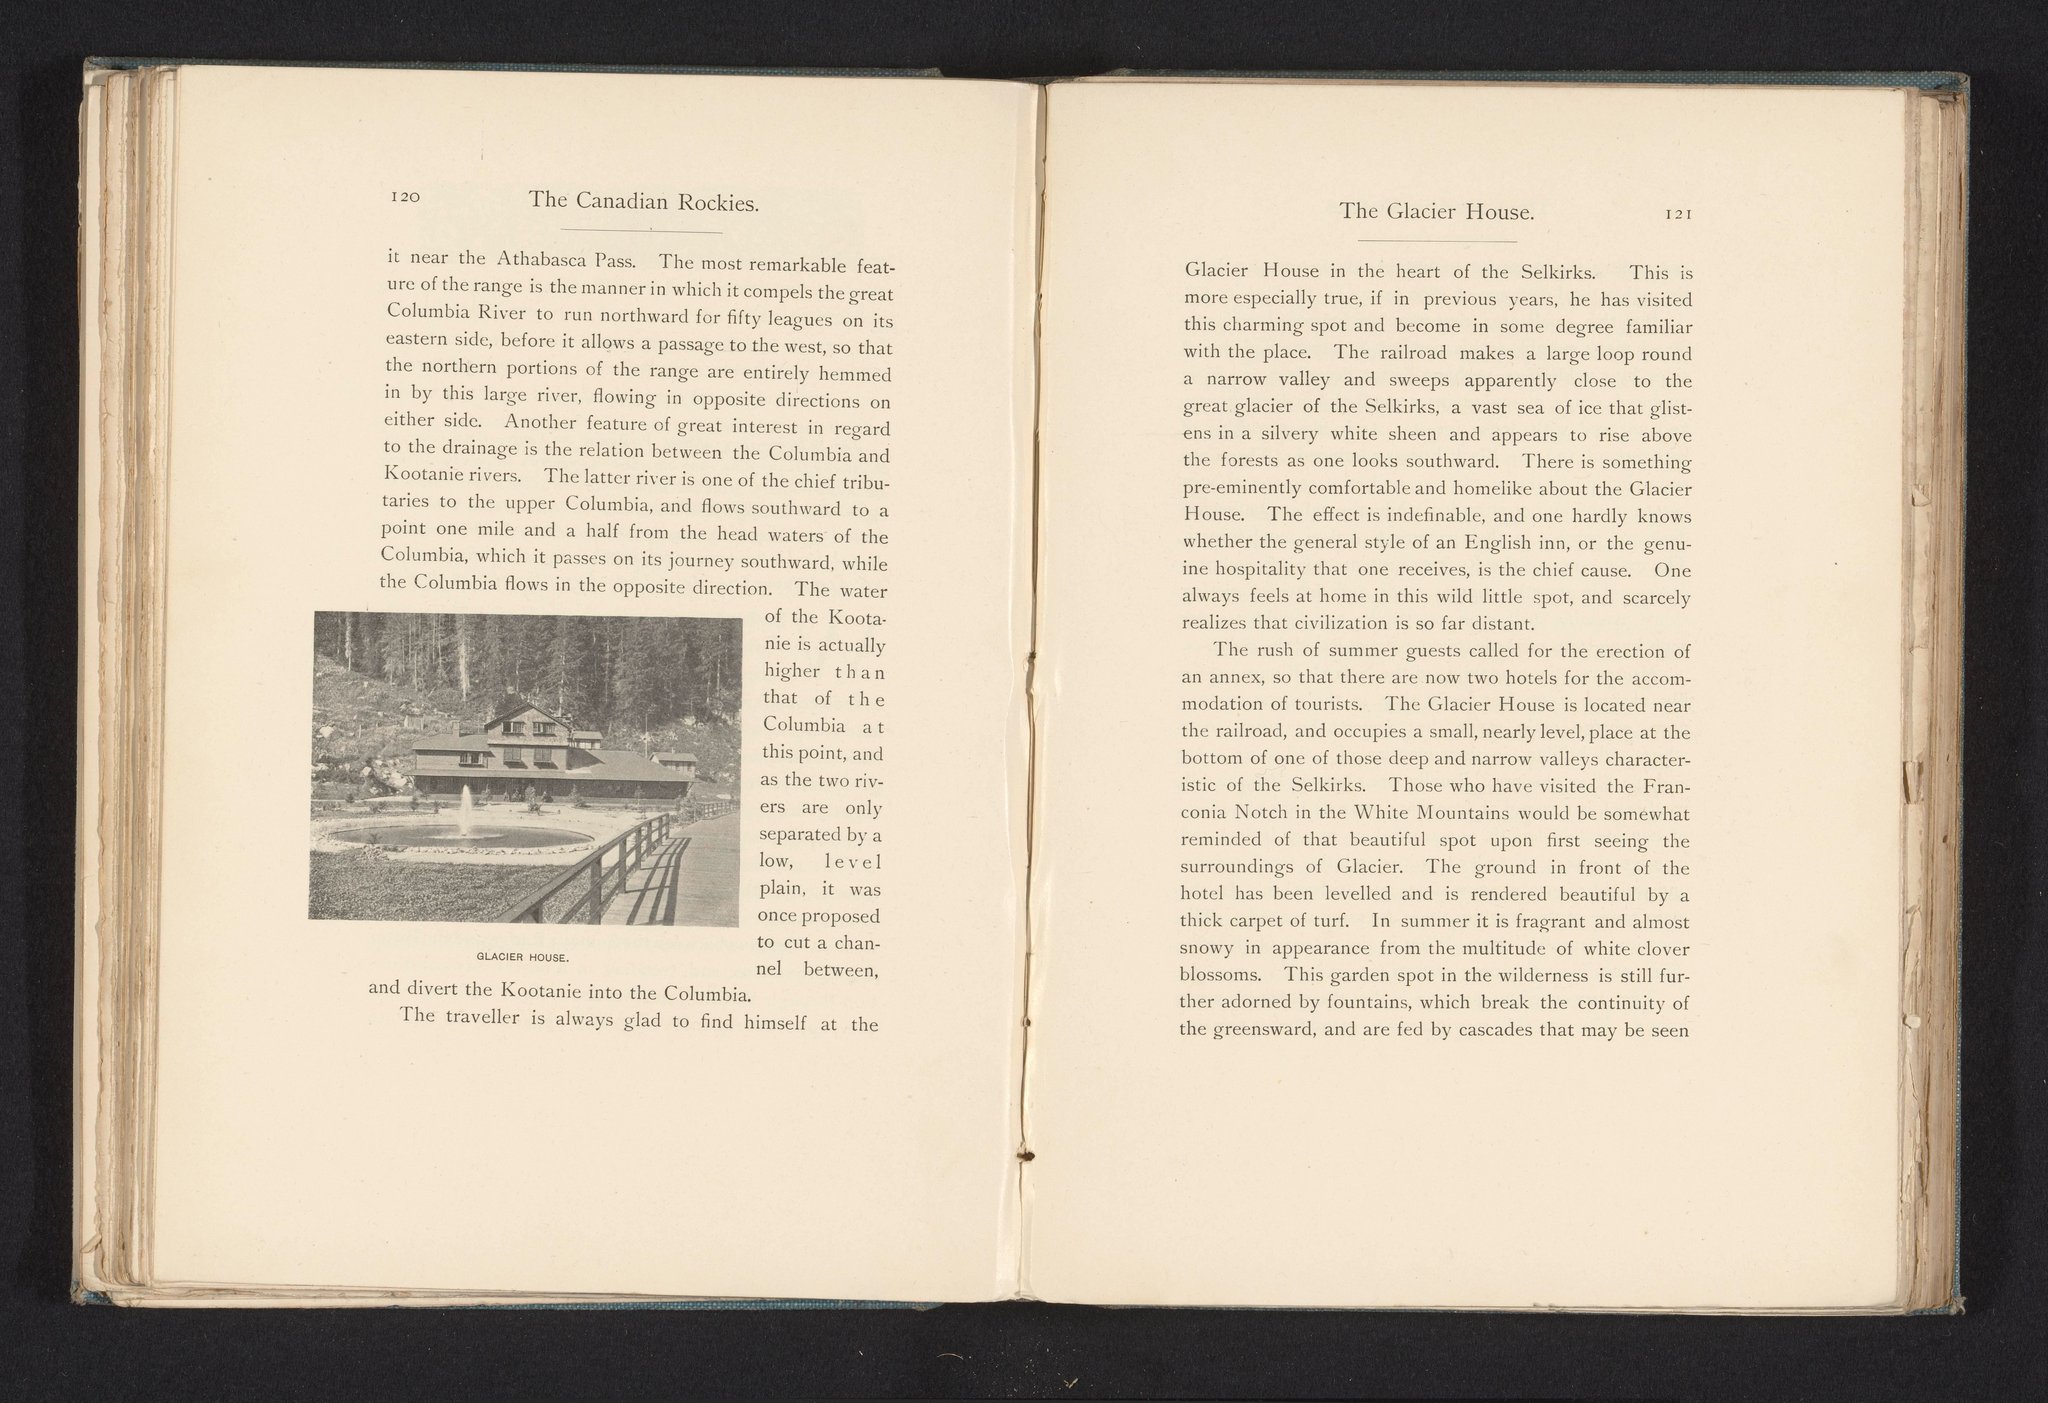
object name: photomechanical print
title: Glacier House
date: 1893-1897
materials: paper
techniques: autotype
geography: british columbia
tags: façade (of house or building), hotel, hostelry, inn